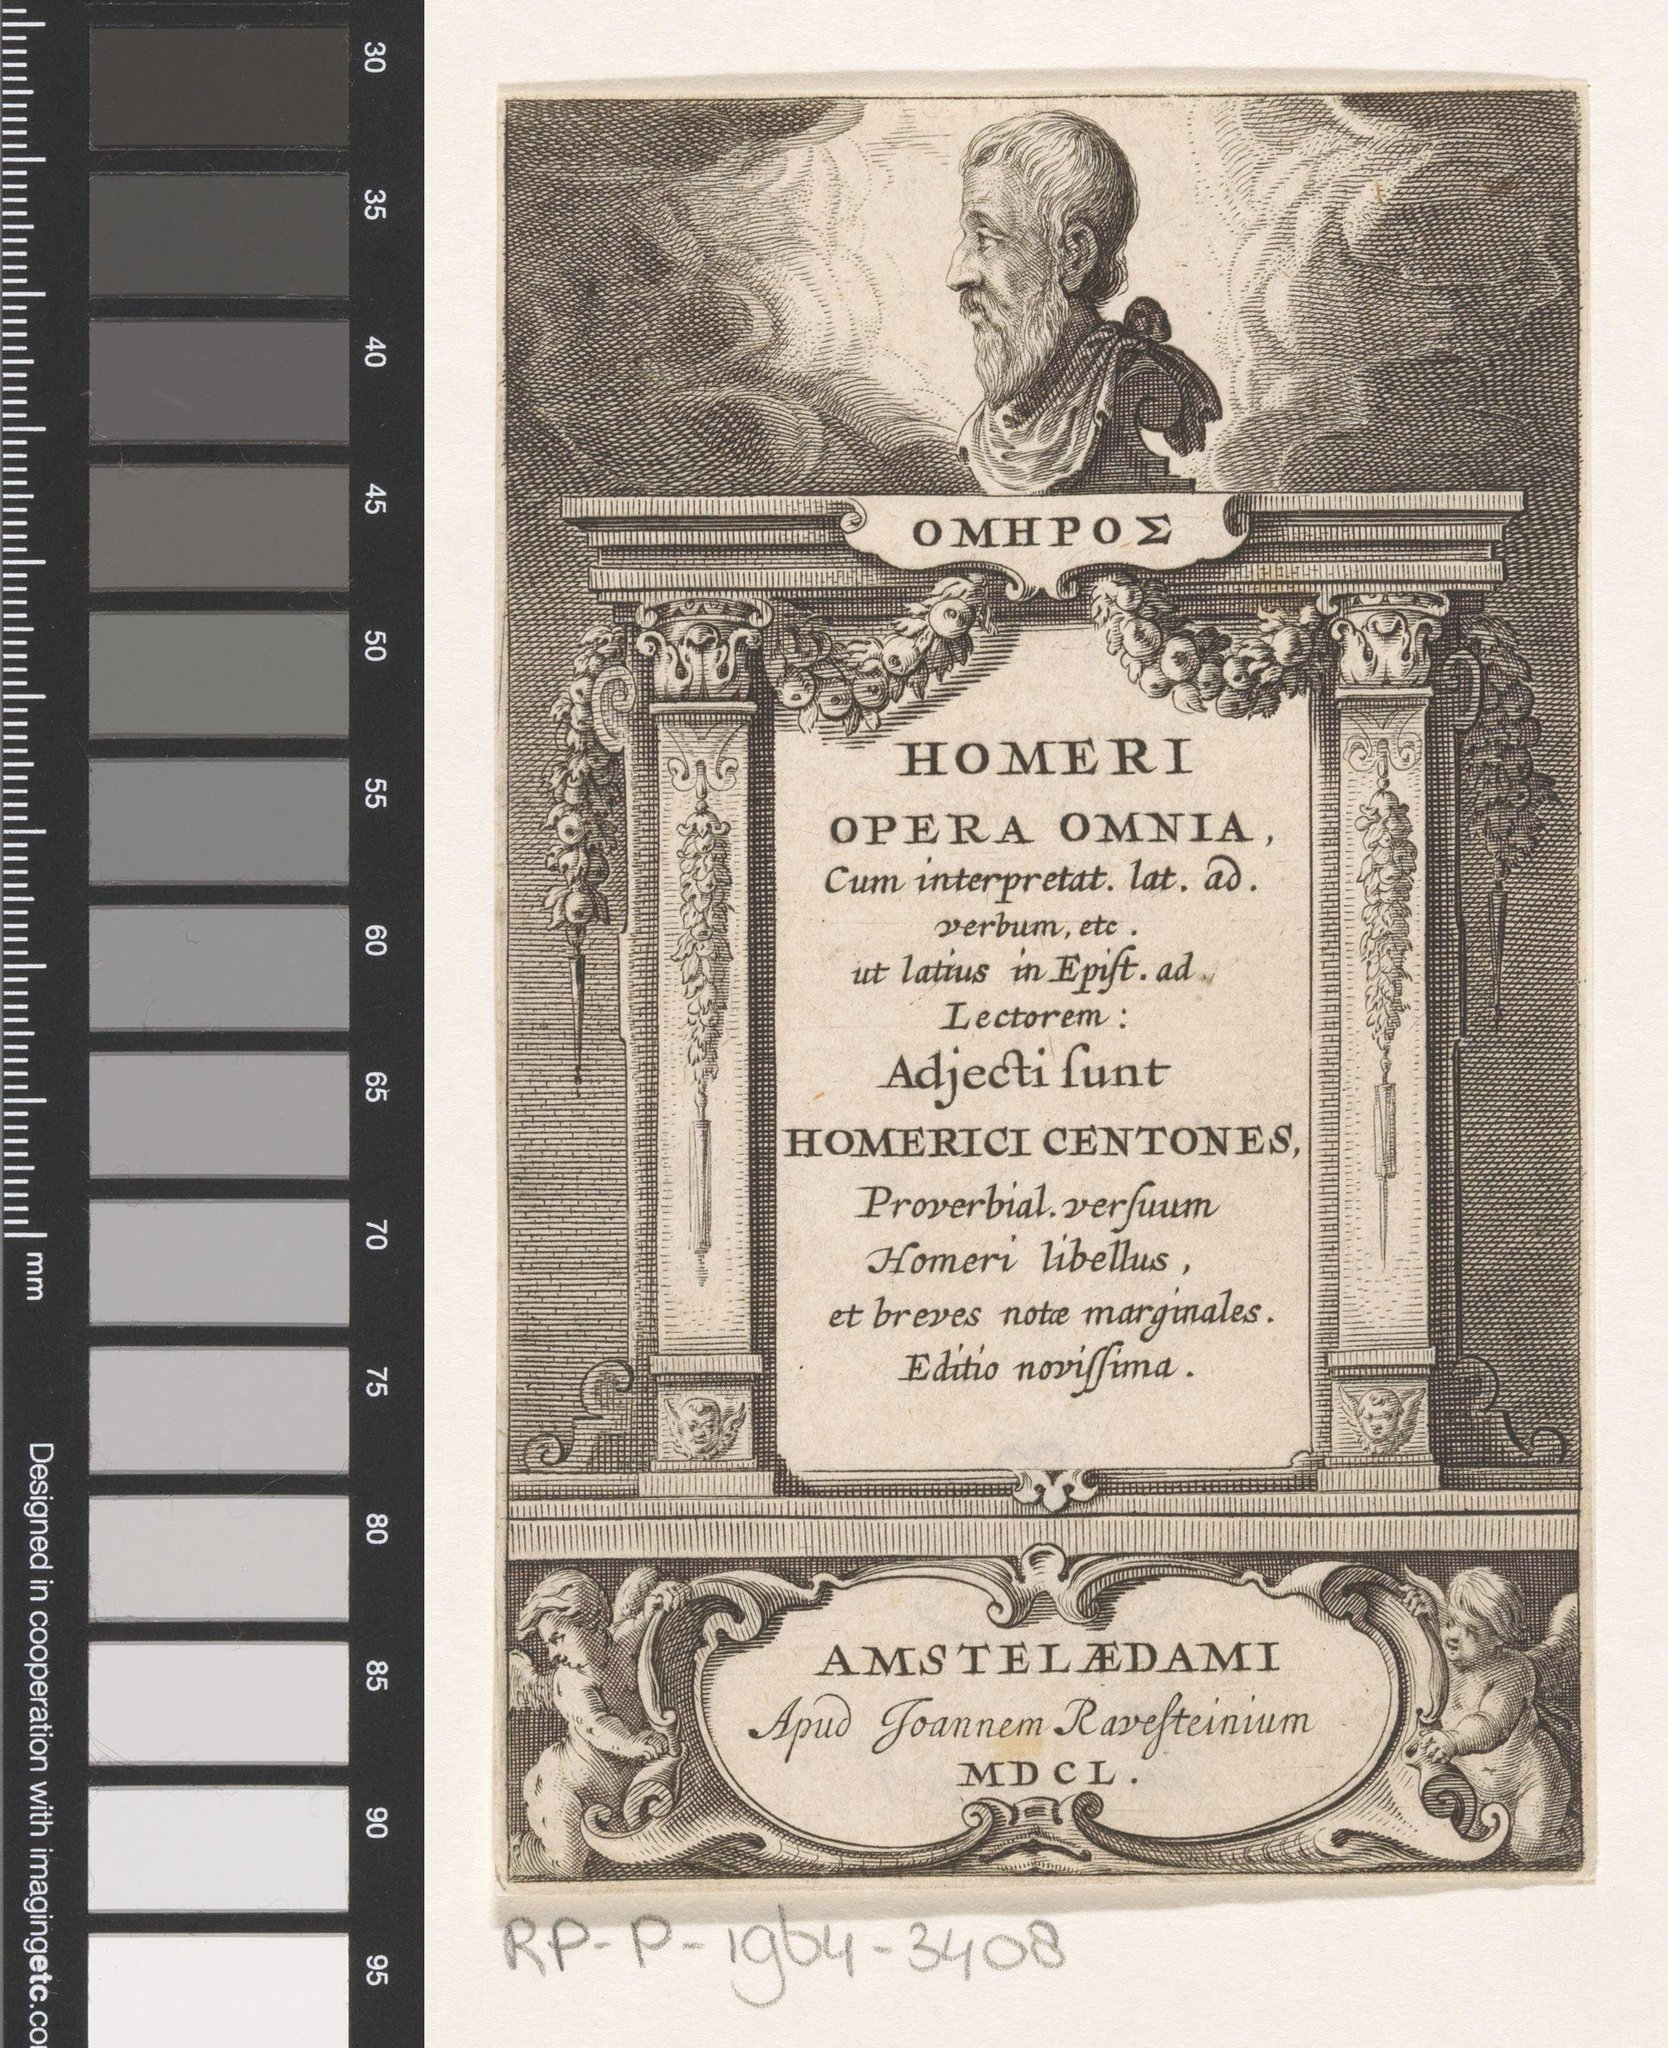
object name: print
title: Buste van Homerus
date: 1650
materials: paper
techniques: engraving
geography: amsterdam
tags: homerus, (story of) homer (+ head, bust, etc.)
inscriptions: collector's mark: Lugt 2760, collector's mark: Lugt 2228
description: Buste van Homerus naar links omgeven door wolken op een voetstuk met de titel van het boek.